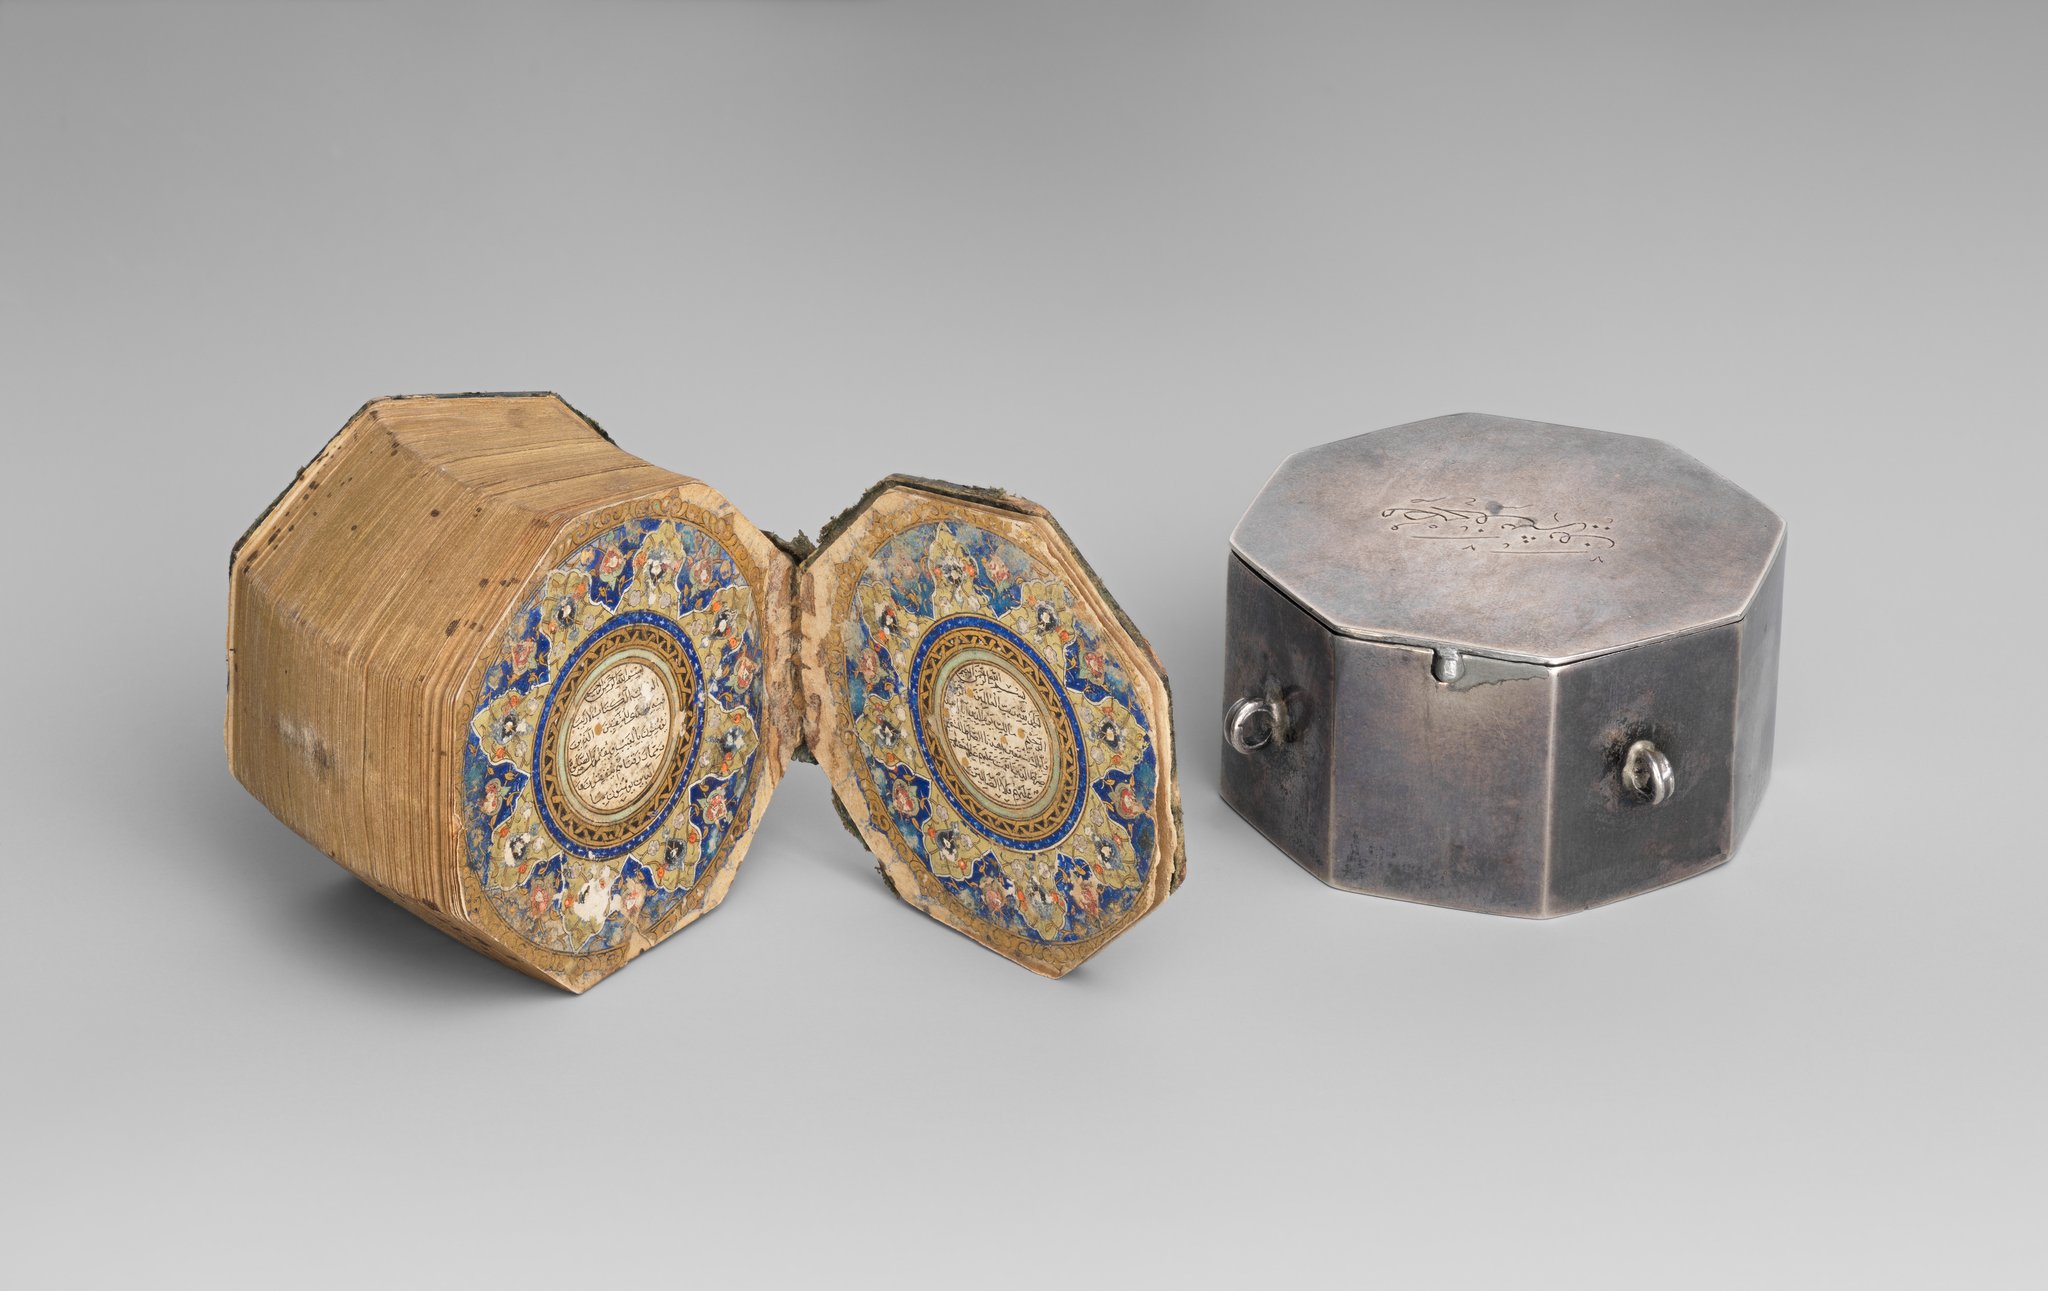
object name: non illustrated manuscript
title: Miniature Qur'an and Qur'an Case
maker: muhammad al-qari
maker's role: calligrapher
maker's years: 1520-1605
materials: gold, ink, paper, silver, watercolor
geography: afghanistan